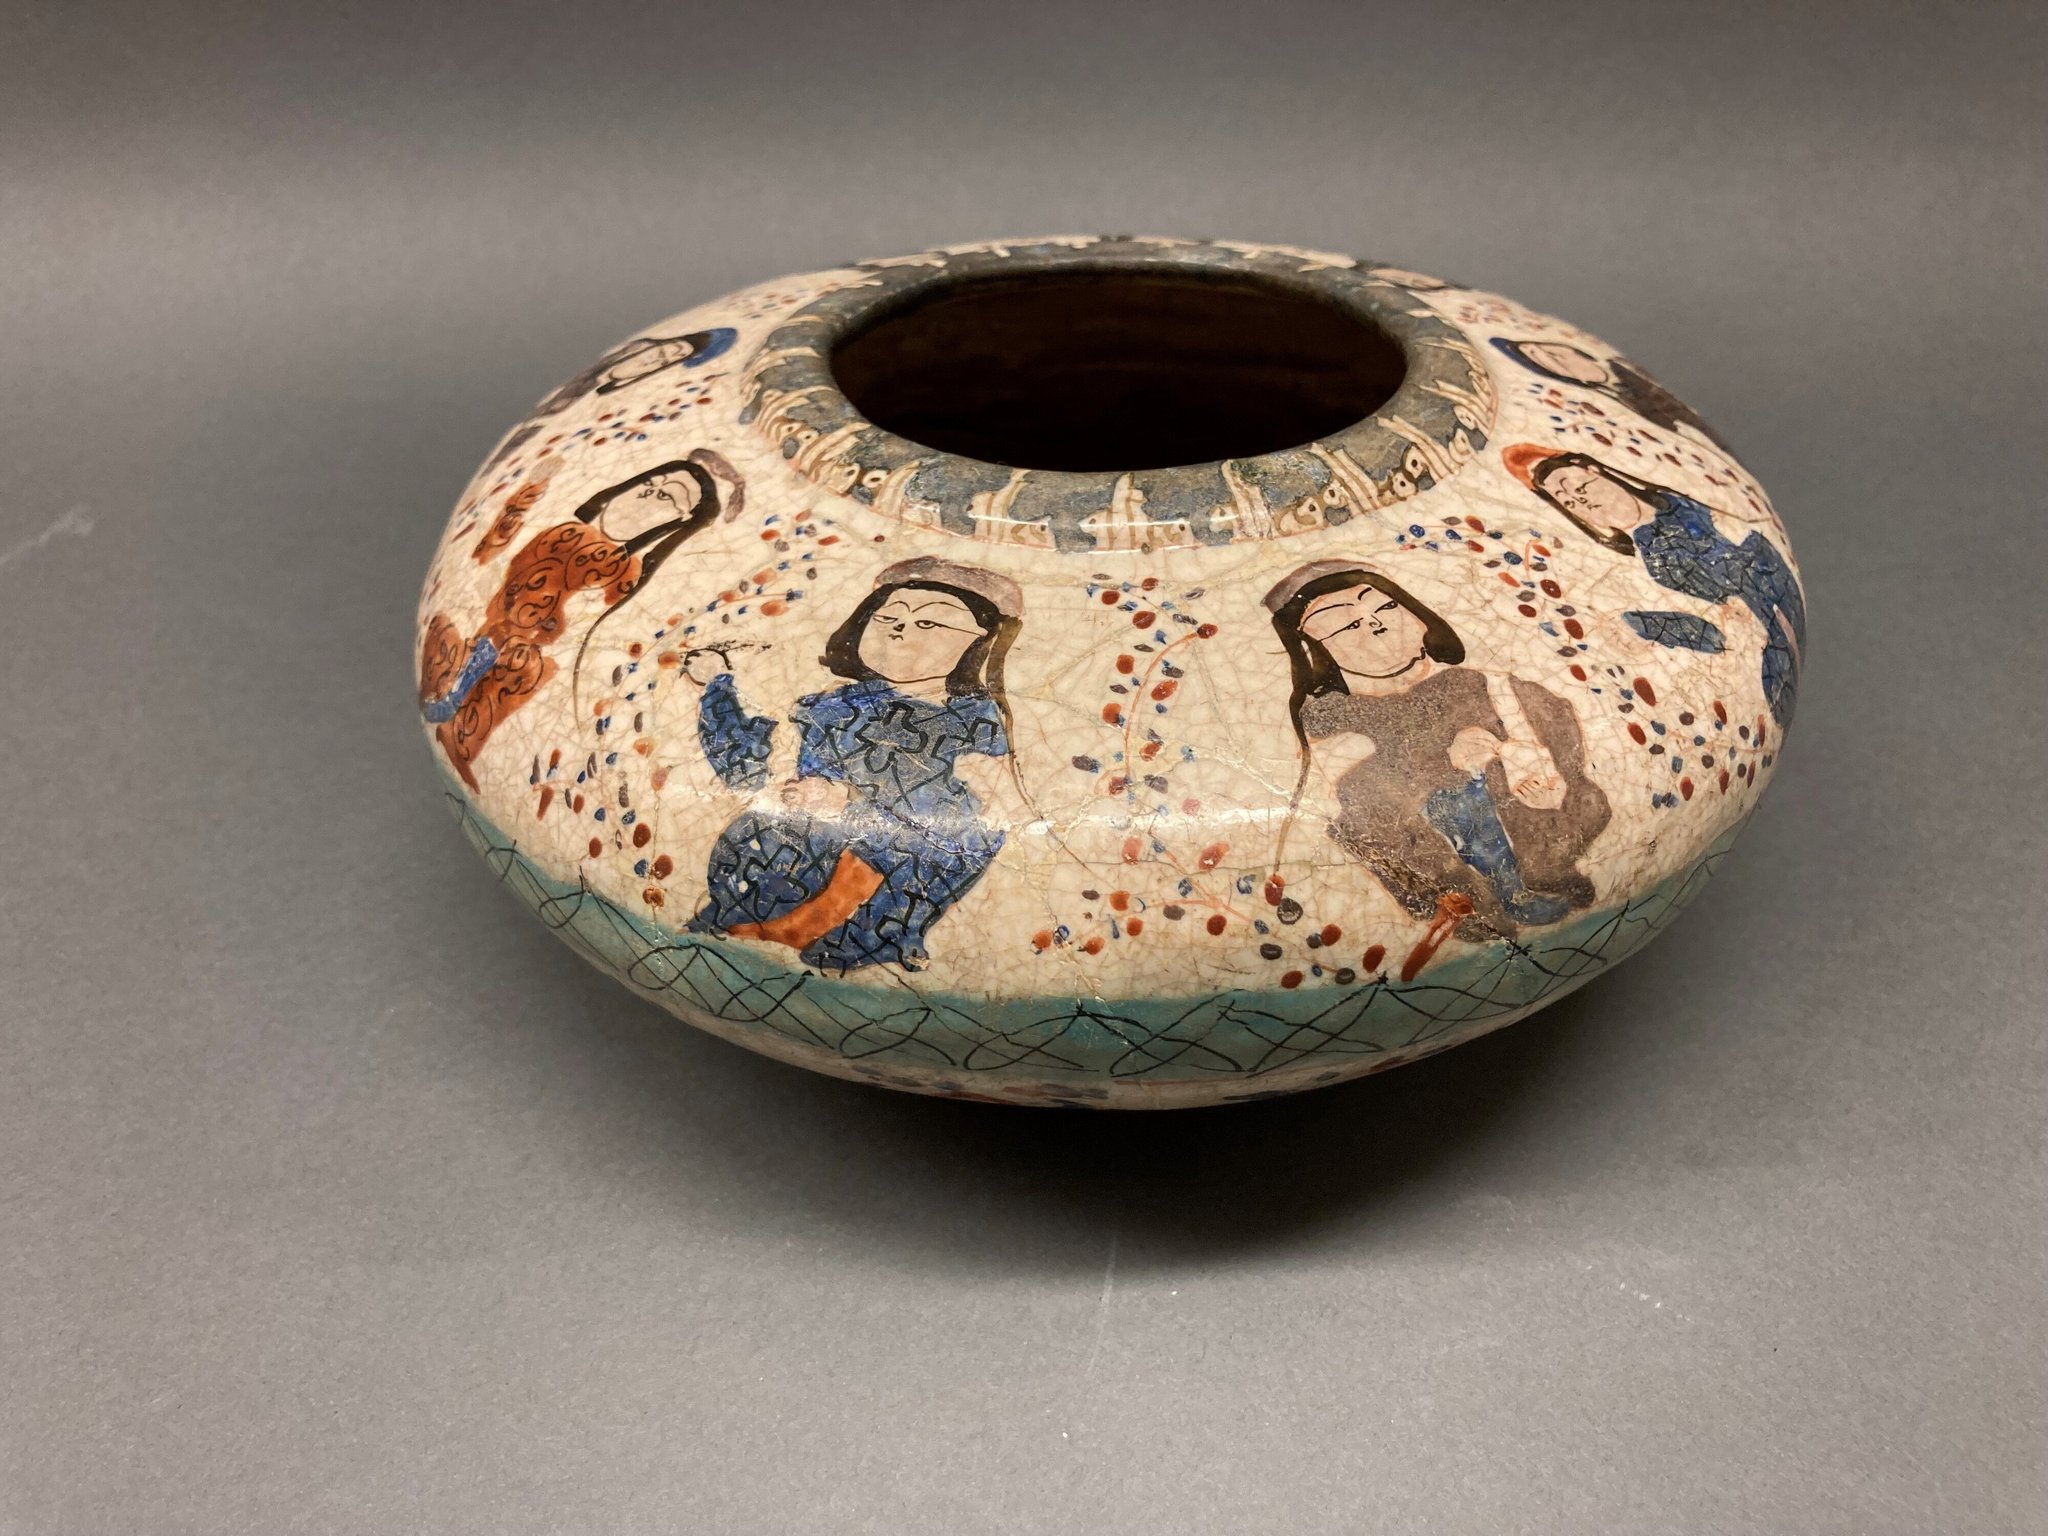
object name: bowl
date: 1101-1300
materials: stonepaste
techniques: overglaze, painting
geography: iran